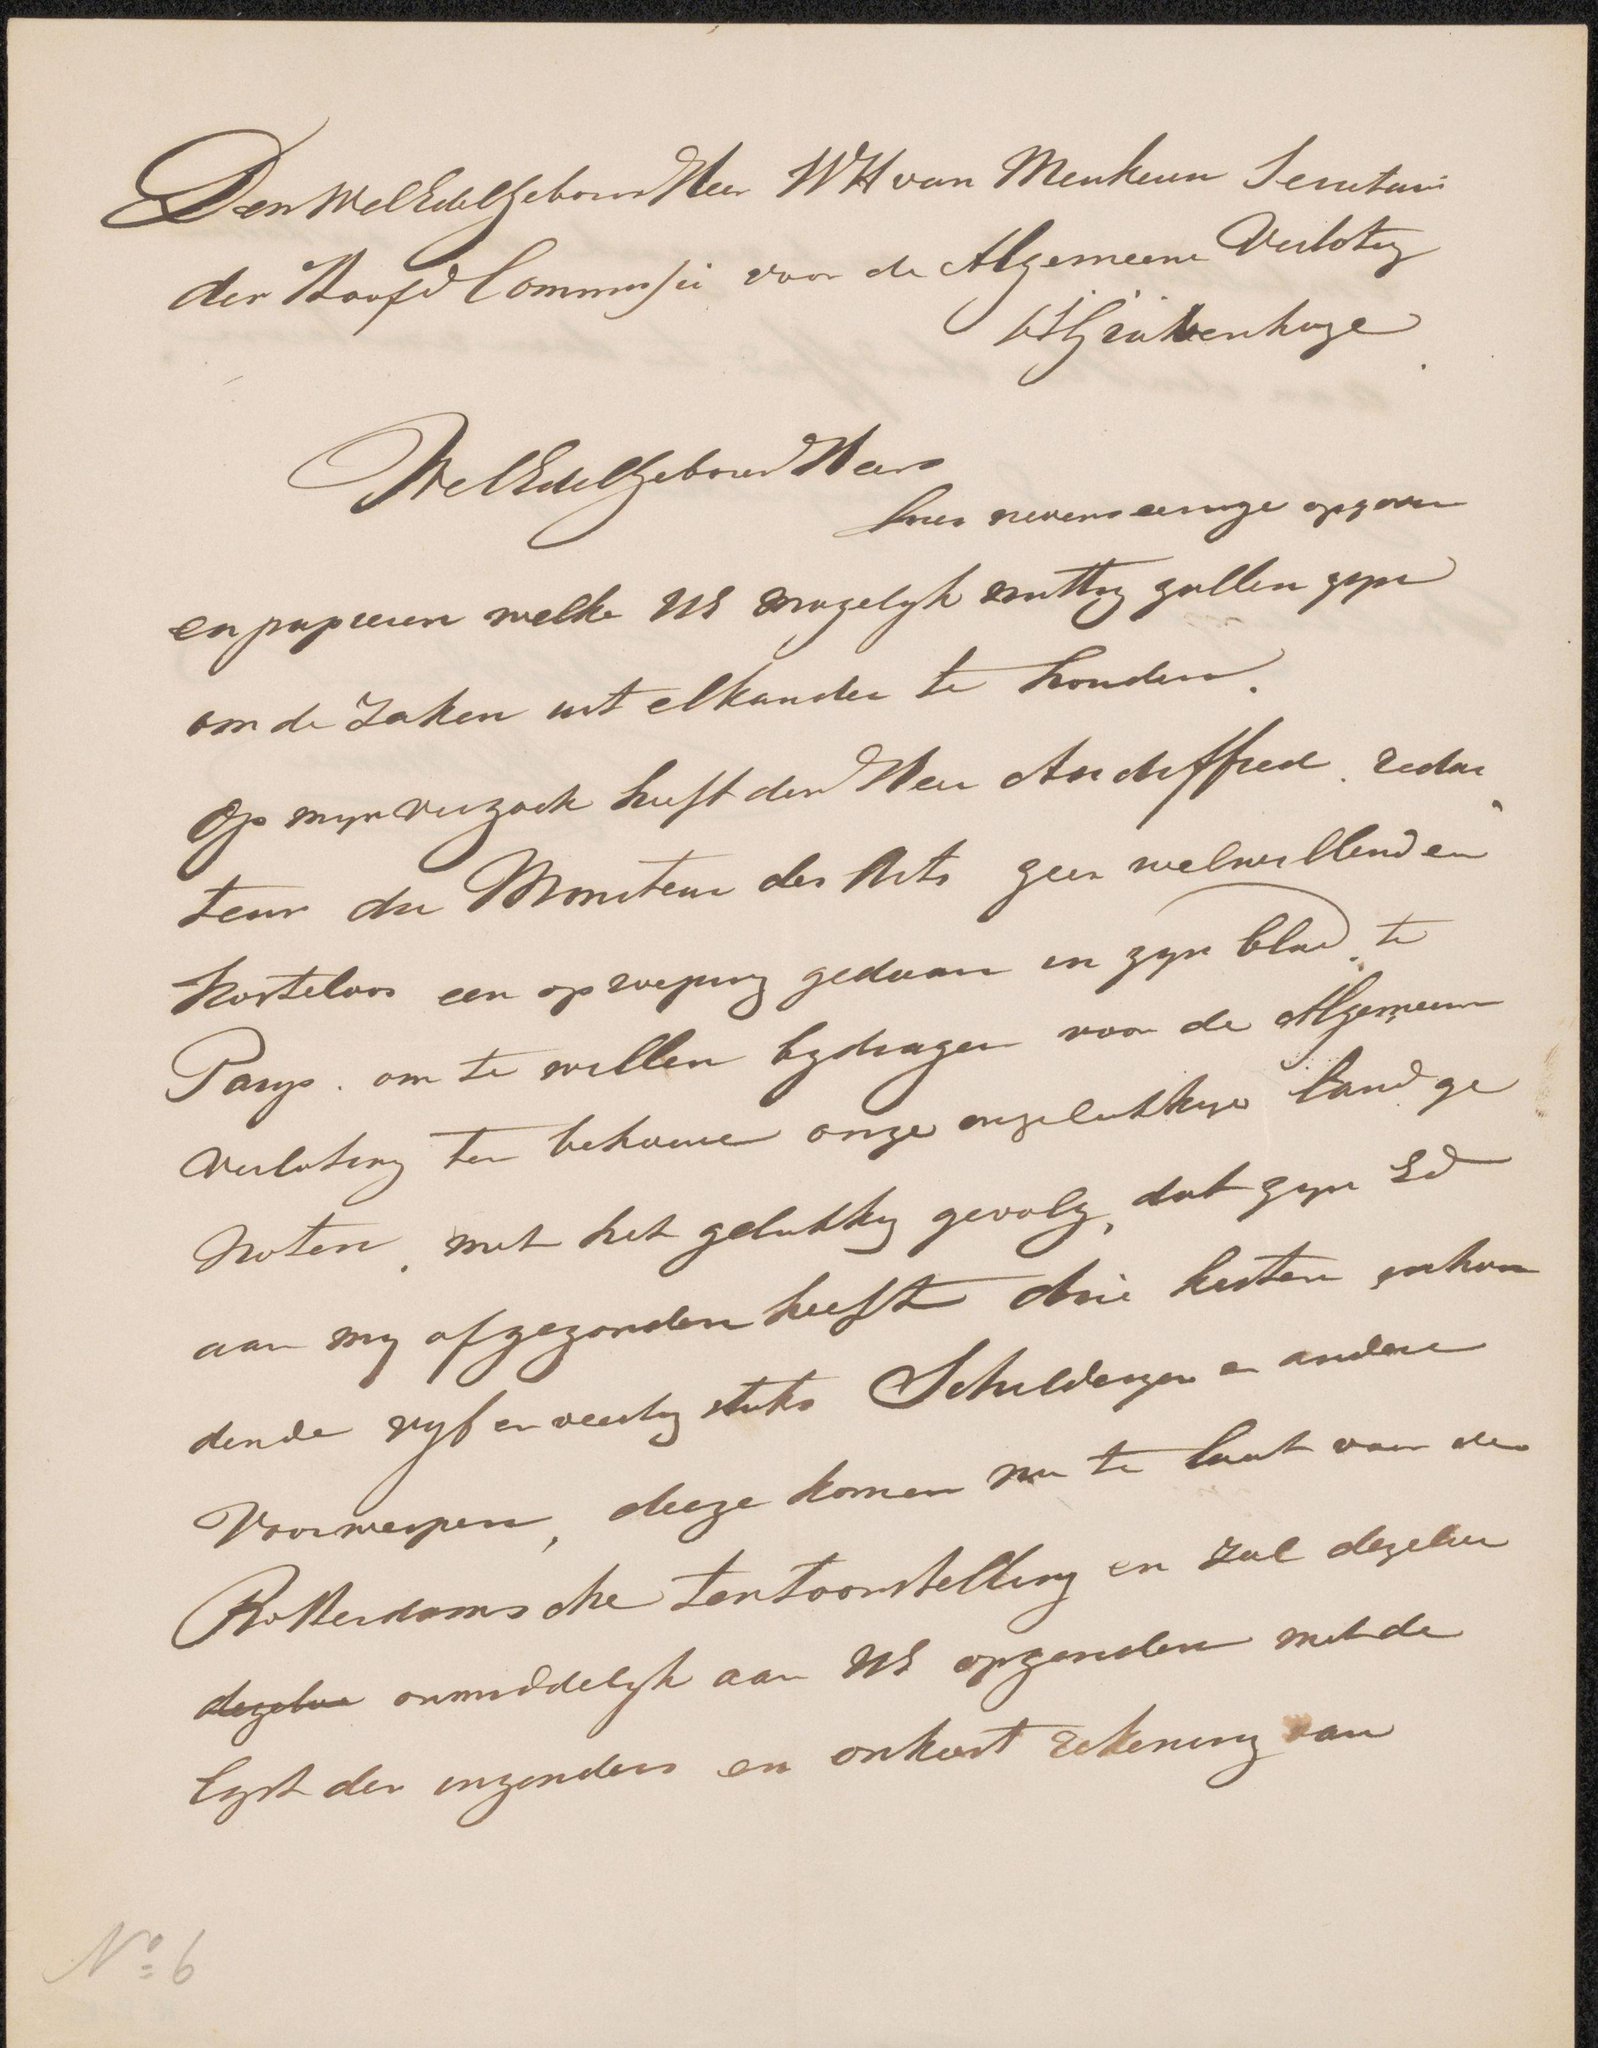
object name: letter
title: Brief aan de secreteris van de commissie van de Algemeene Verloting in Den Haag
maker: ary johannes lamme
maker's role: draughtsman, print maker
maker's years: 1812-1900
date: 1822-1900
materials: ink, paper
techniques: pen, writing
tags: painting (including book-illumination, miniature-painting), exhibition ~ art, rotterdam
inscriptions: collector's mark: Lugt 2233